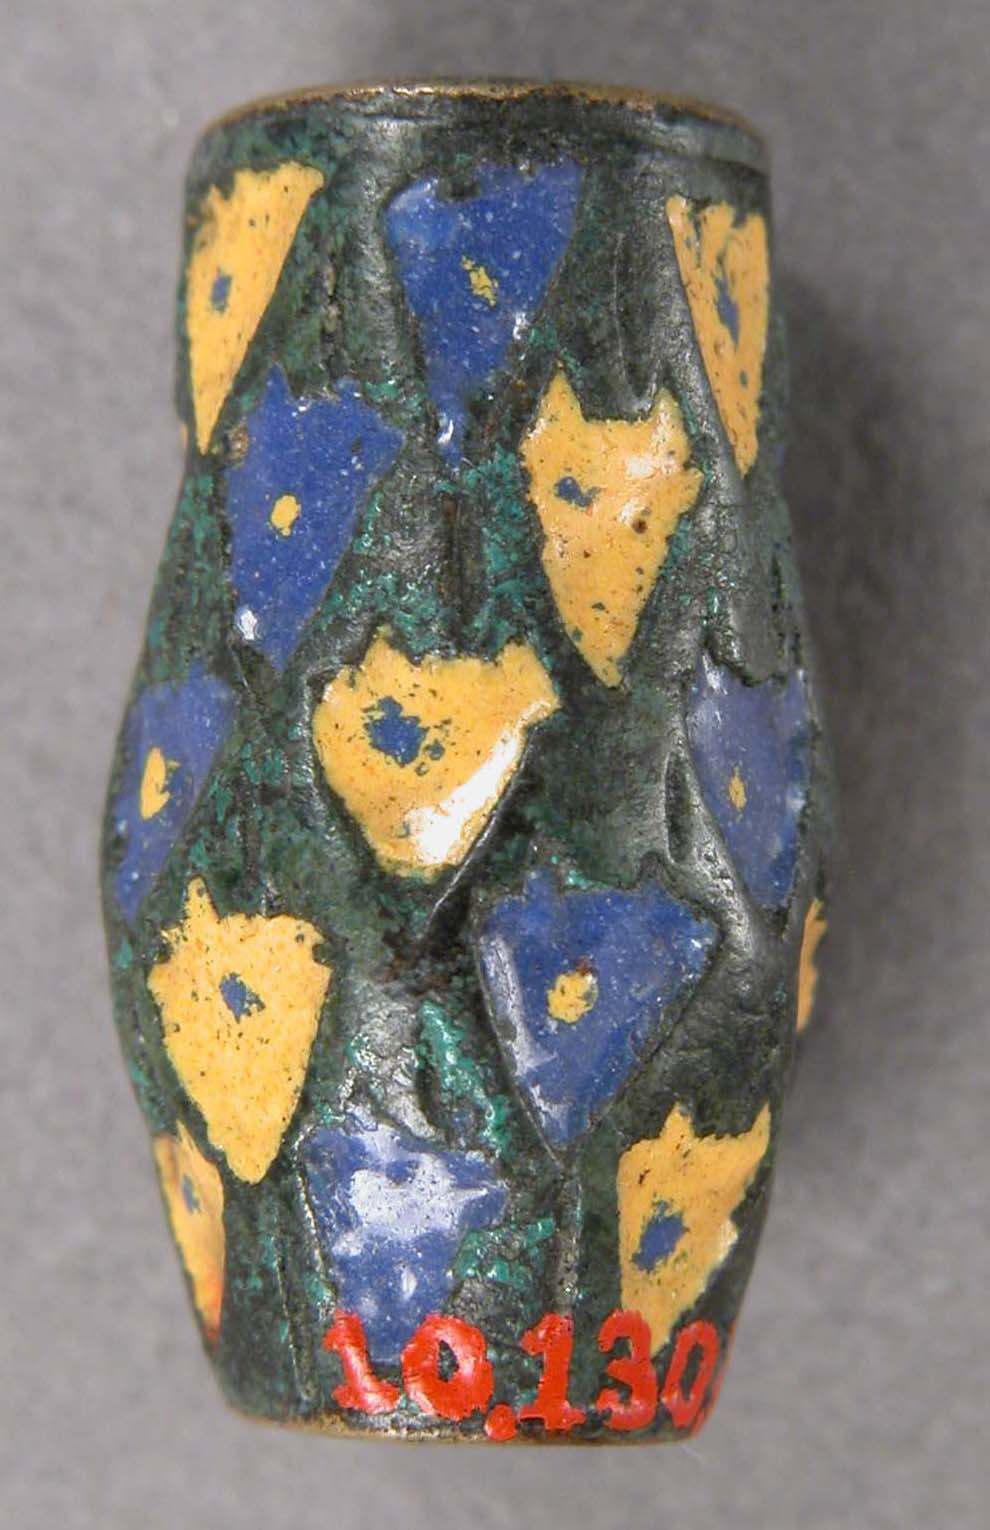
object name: bead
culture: coptic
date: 301-700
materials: copper alloy, enamel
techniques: enamel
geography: egypt